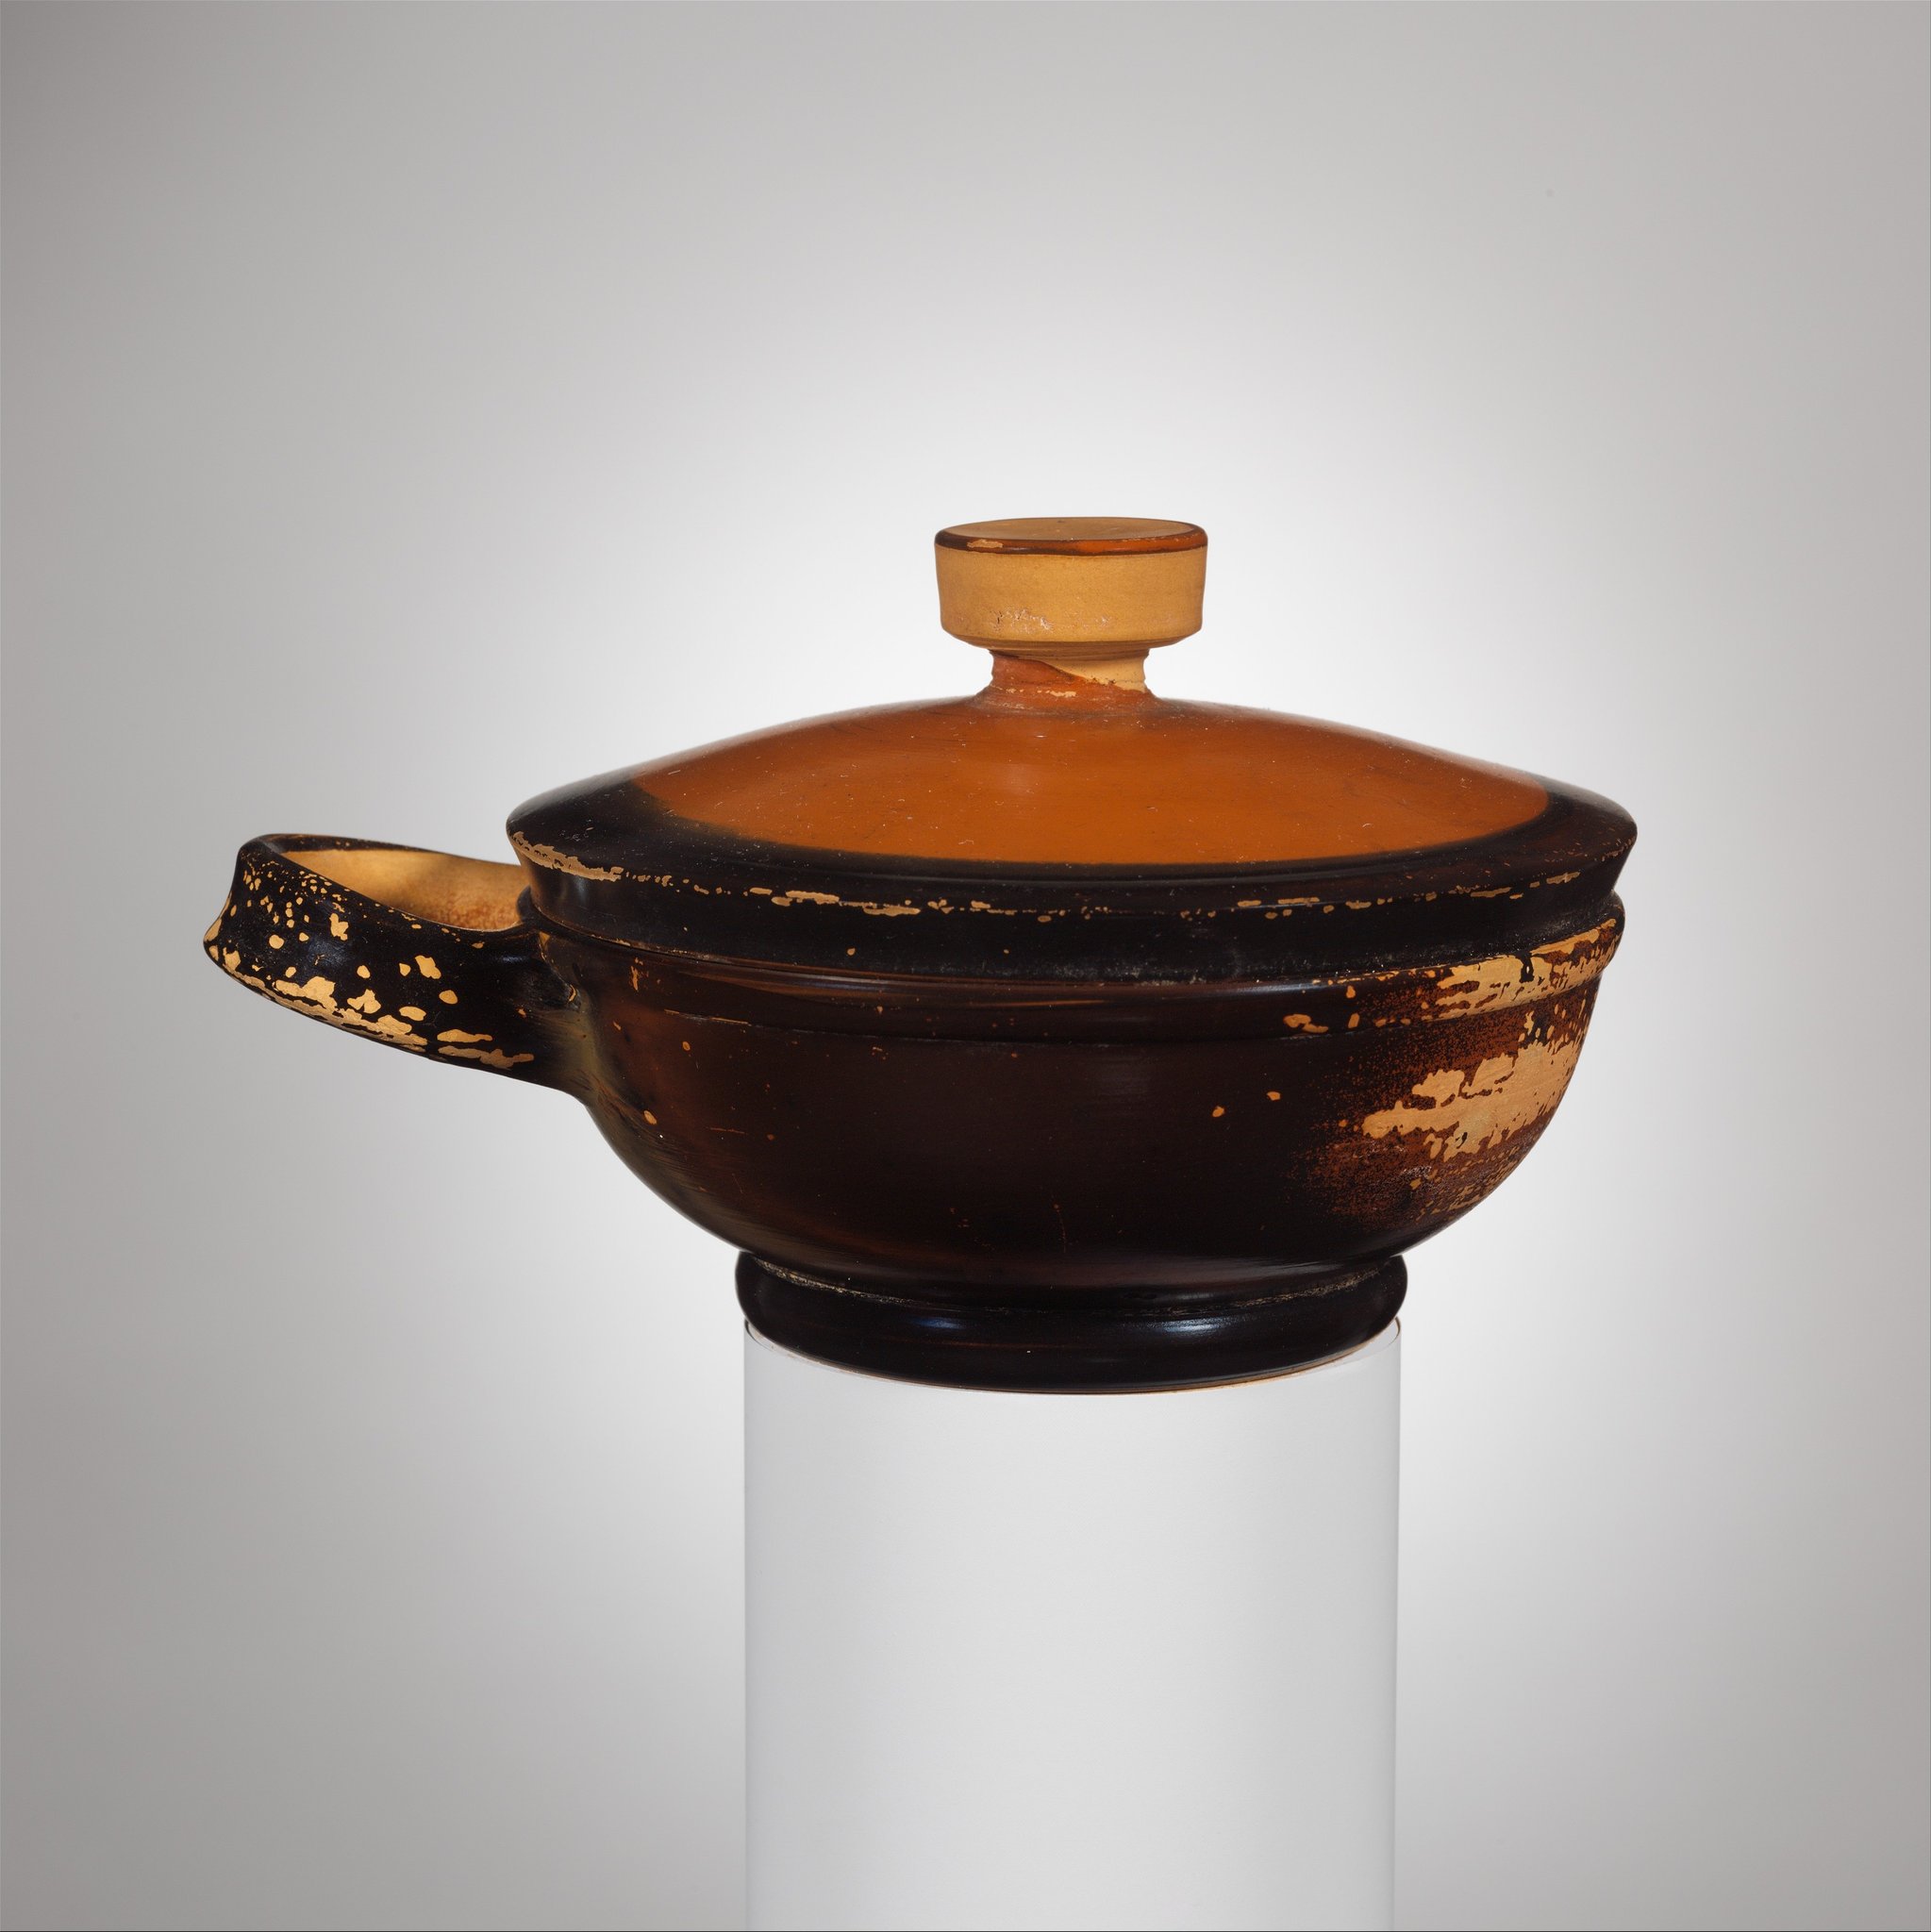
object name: bowl with lid and one handle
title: Terracotta covered bowl with one handle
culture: greek, attic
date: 450-400 BCE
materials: terracotta